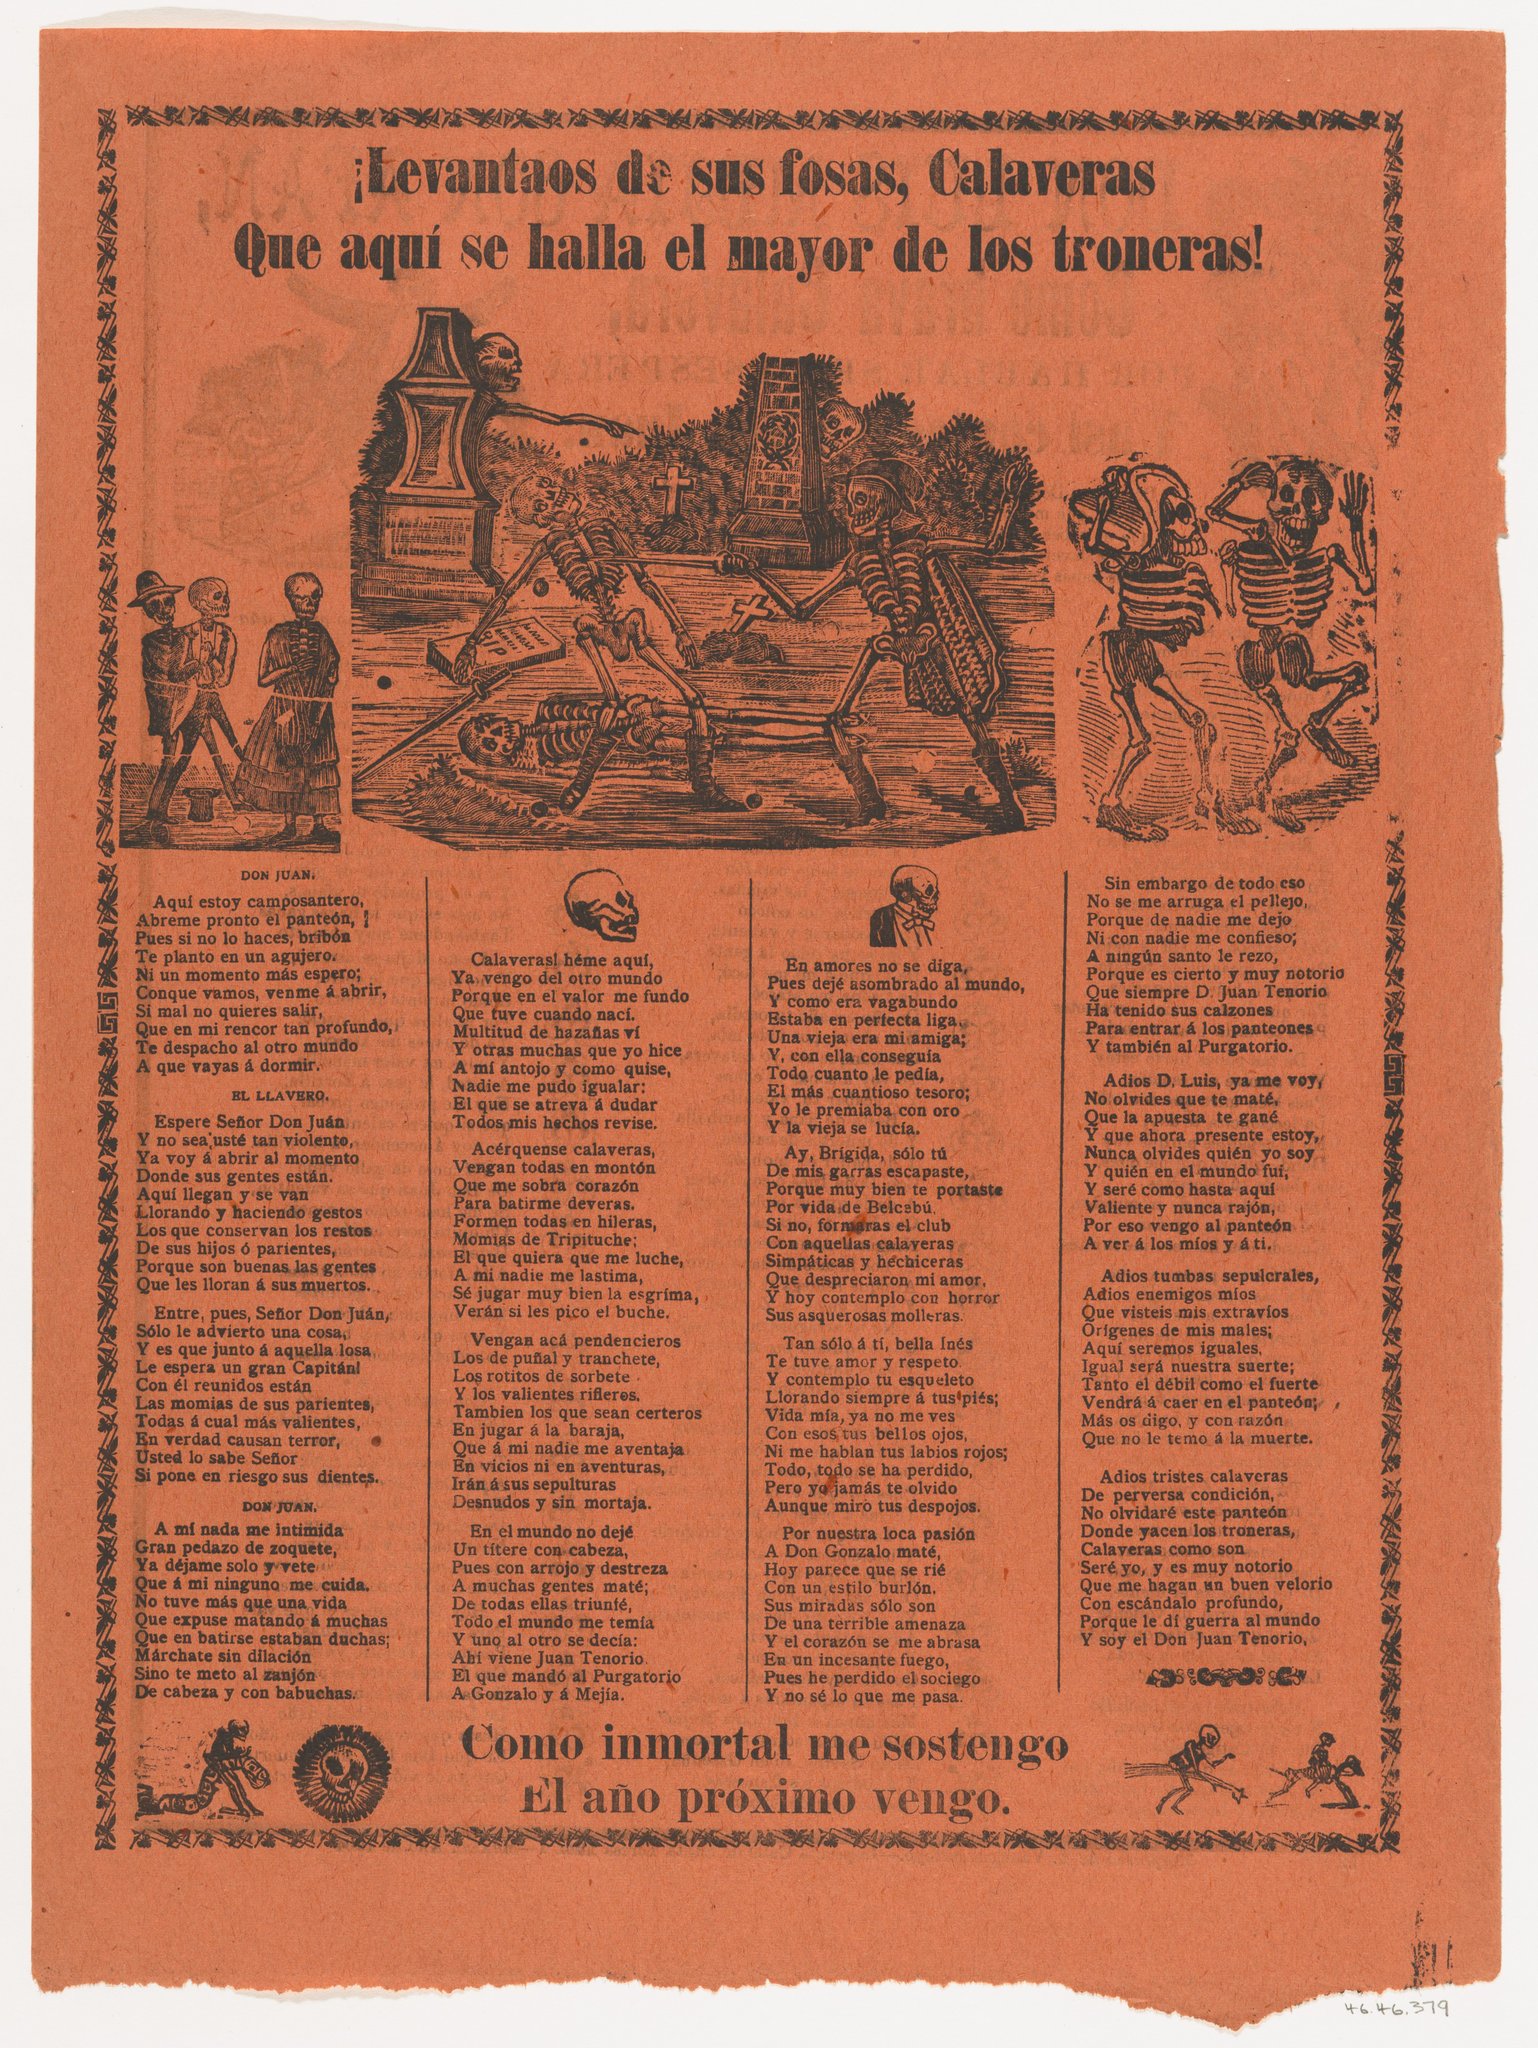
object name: print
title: Broadsheet relating to skeletons rising from their graves, two skeletons duelling with swords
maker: josé guadalupe posada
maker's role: artist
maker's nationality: mexican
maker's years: 1852-1913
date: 1904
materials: metal, paper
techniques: engraving, letterpress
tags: skeletons